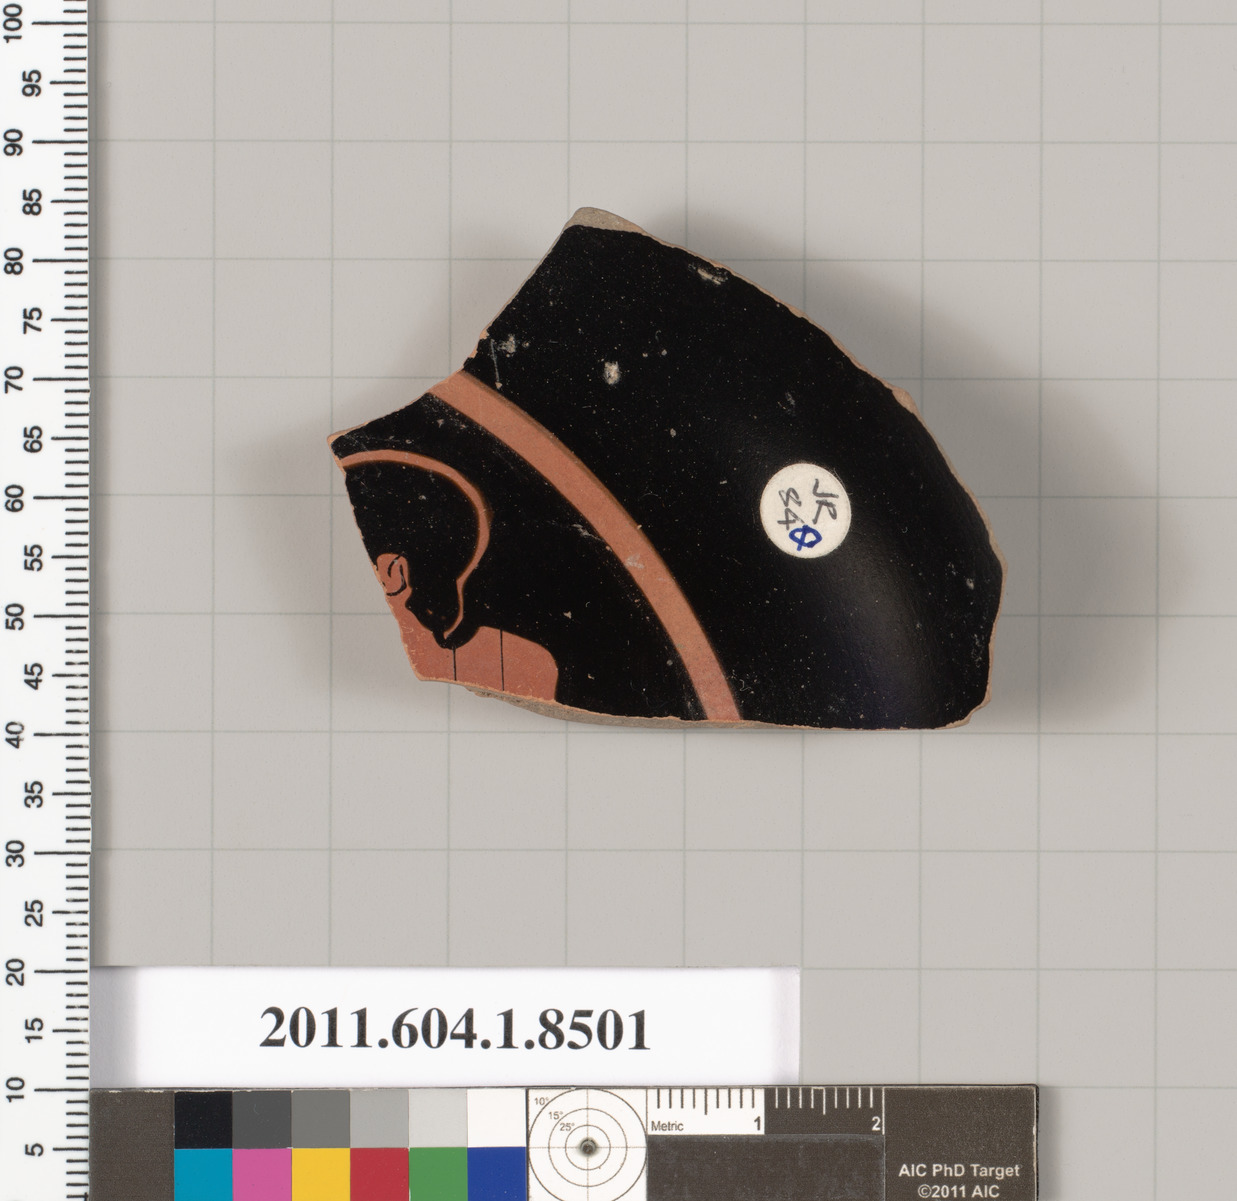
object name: kylix fragment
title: Terracotta fragment of a stemless kylix (drinking cup)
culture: greek, attic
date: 475-451 BCE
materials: terracotta